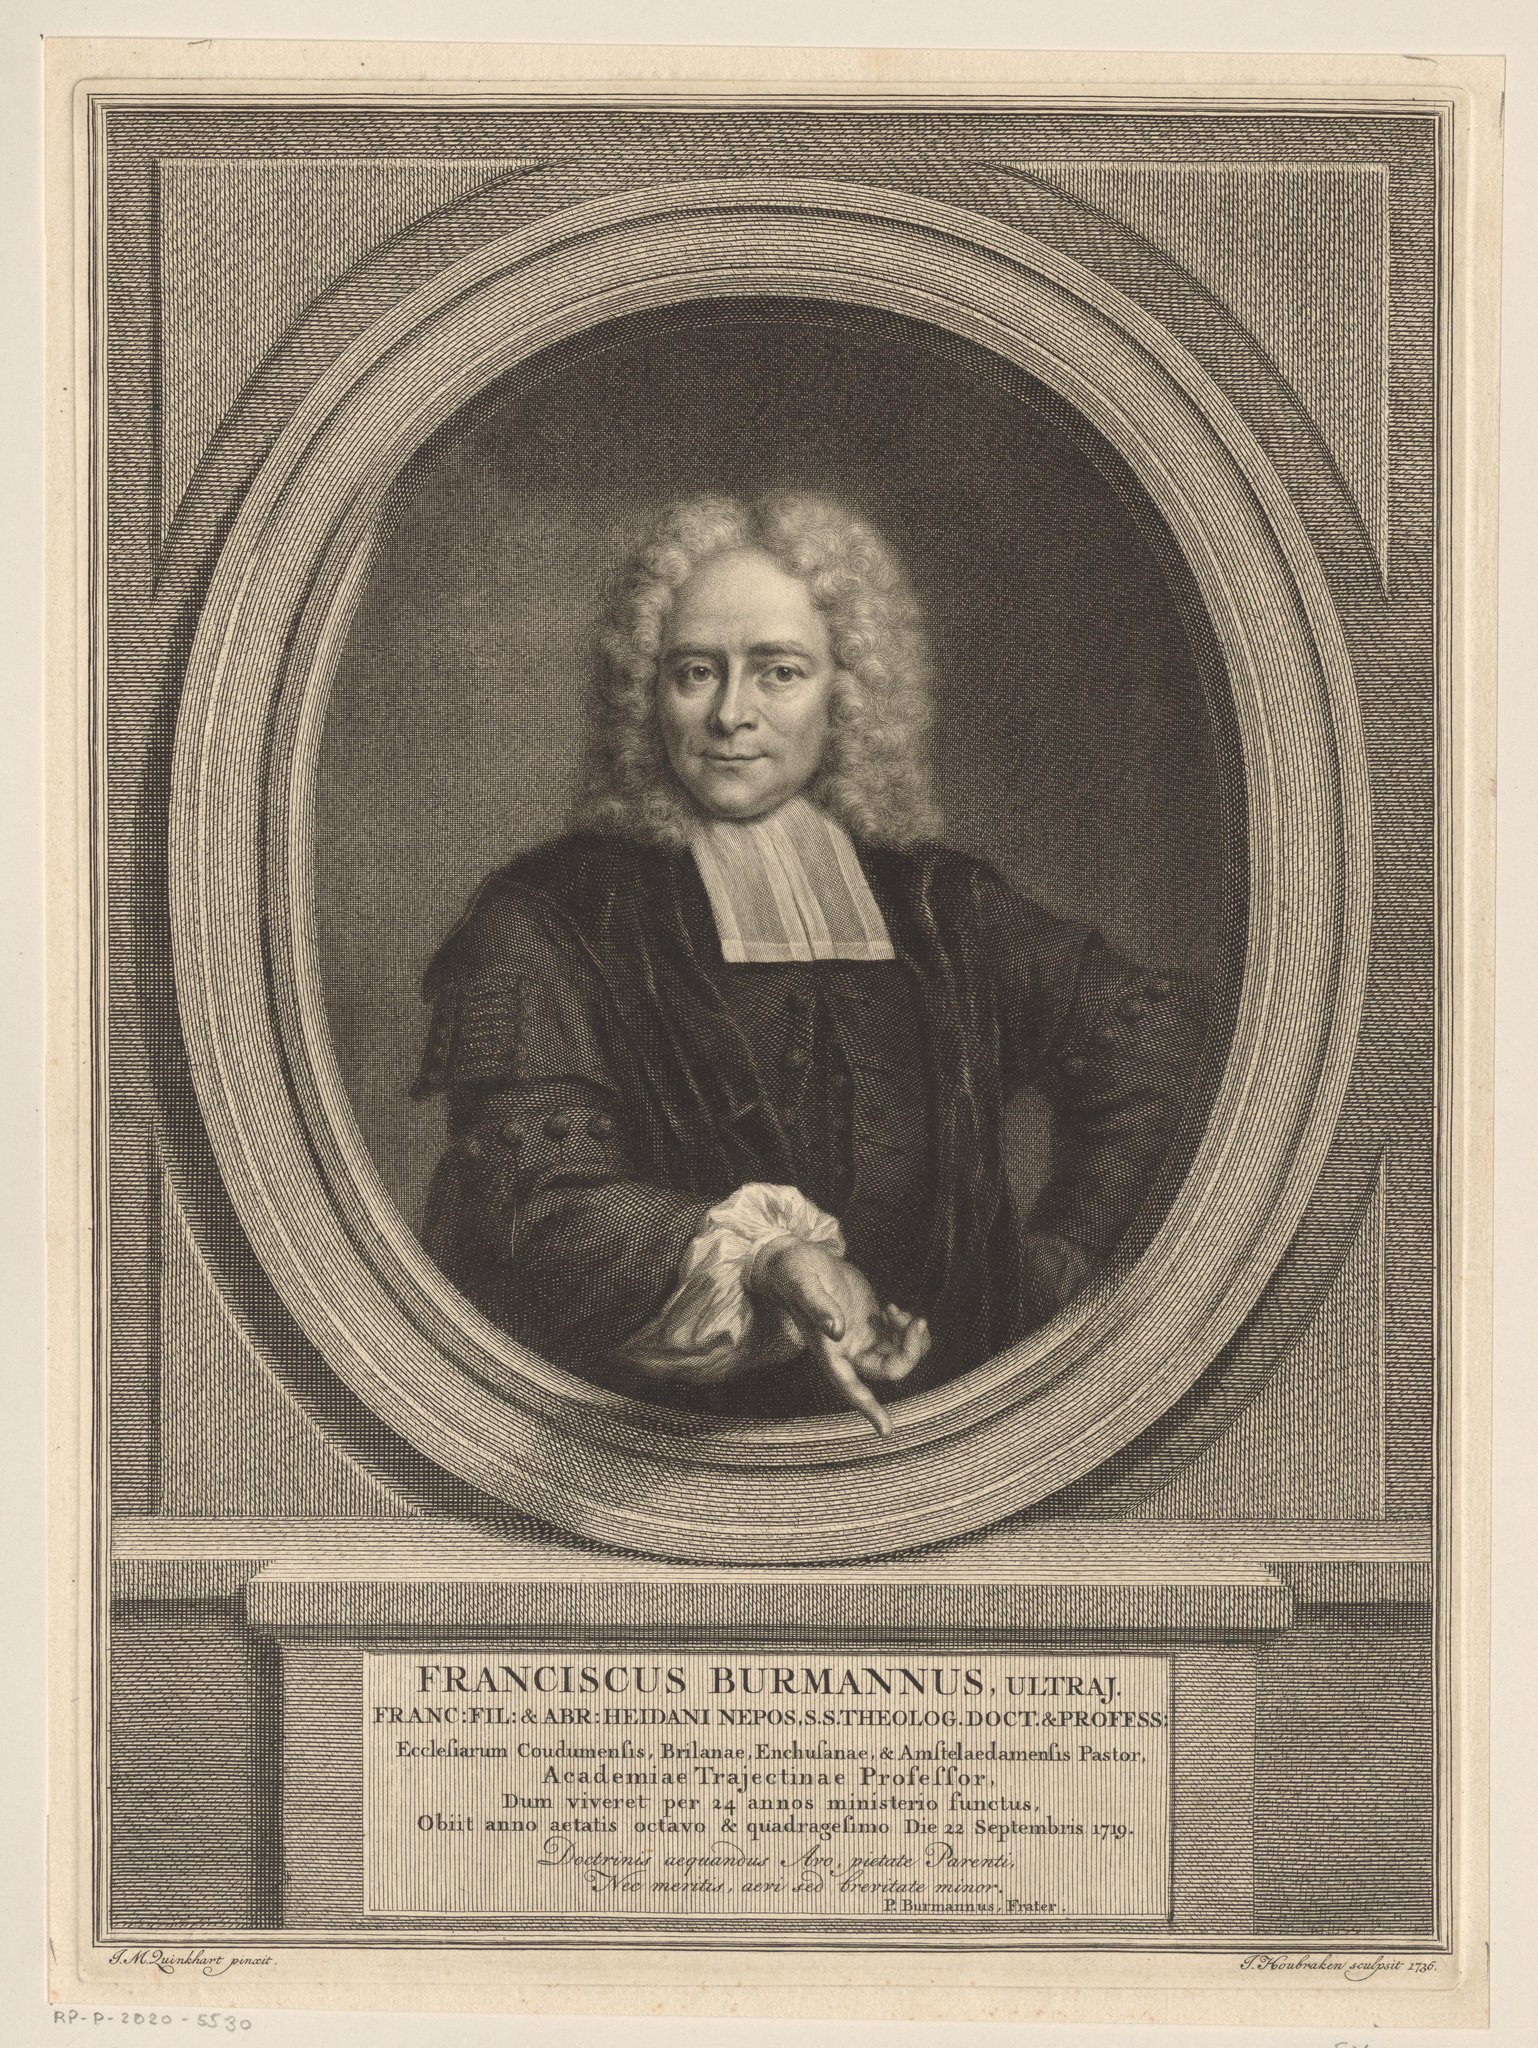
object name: print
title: Portret van Franciscus Burman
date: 1736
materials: paper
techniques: engraving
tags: utrecht, scholar, philosopher, historical persons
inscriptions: date